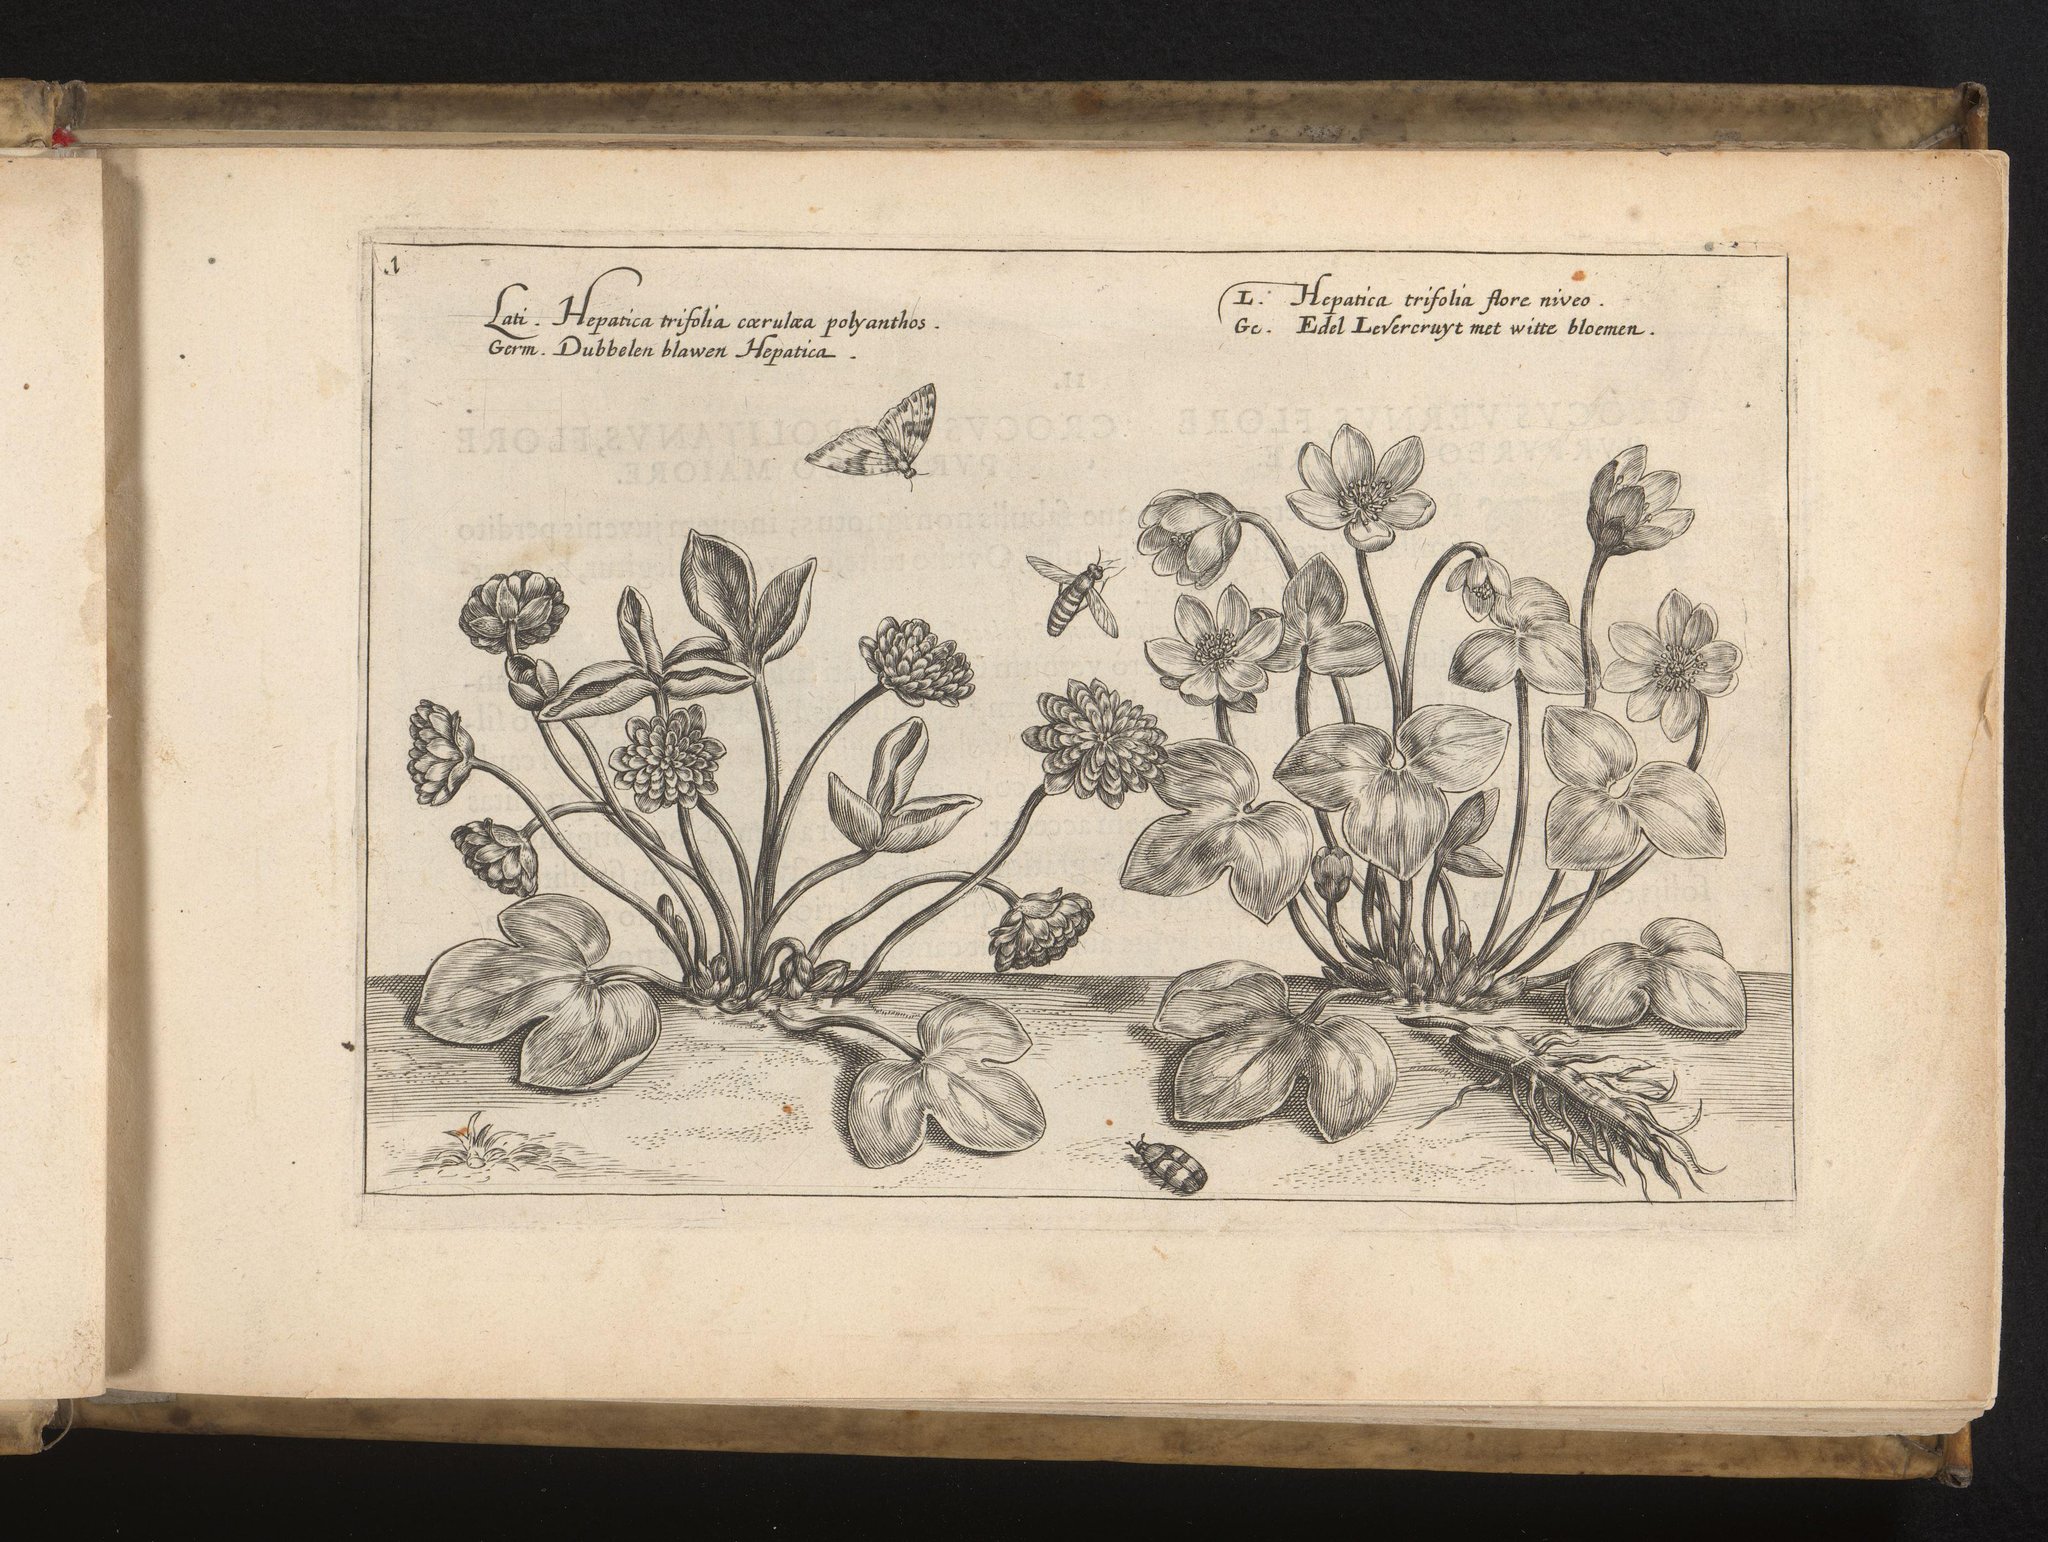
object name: page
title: Leverbloempje en een cultivar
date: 1617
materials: paper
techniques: engraving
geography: utrecht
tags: flowers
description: Prent uit: Passe, Crispijn van de (II). Hortus floridus in quo rariorum & minus vulgarium florum icones ad vivam veramque formam. Arnhem: Johannes Janssonius, 1617.